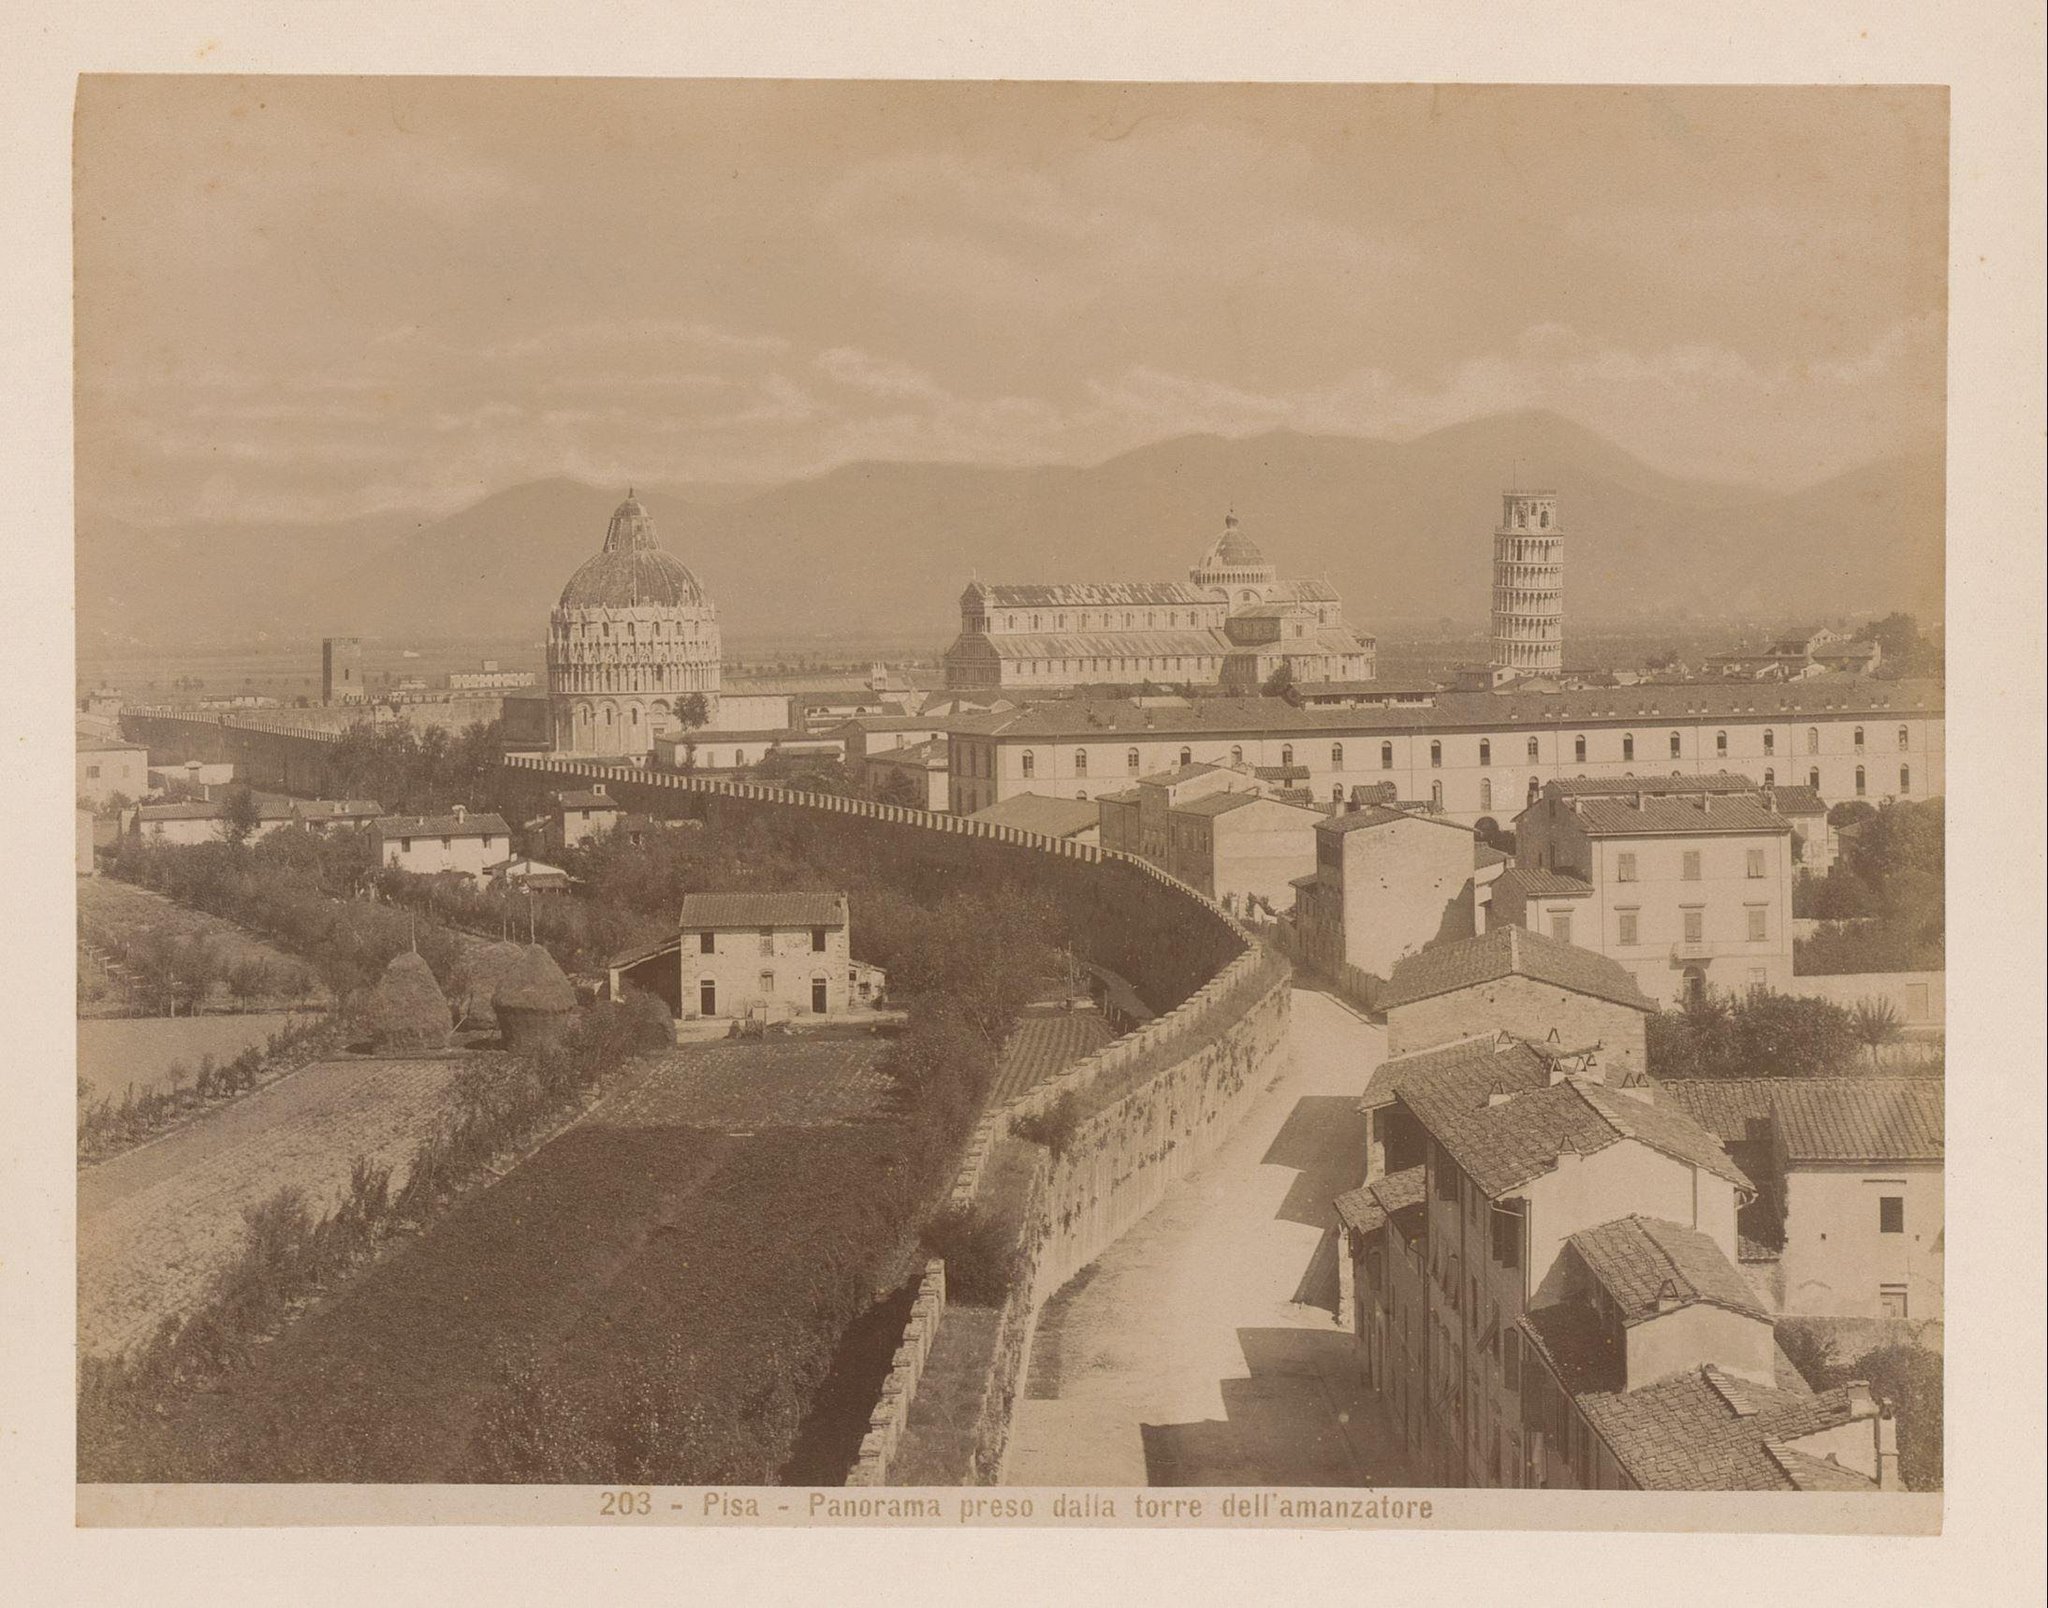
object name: photograph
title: Gezicht op het Piazza del Duomo in Pisa, Italië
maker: giacomo brogi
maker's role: fotograaf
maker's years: 1822-1881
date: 1860-1881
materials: paper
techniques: albumen print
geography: pisa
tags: parts of church exterior and annexes: campanile, city-view in general; 'veduta', church (exterior), city-walls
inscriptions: number: ‘203’